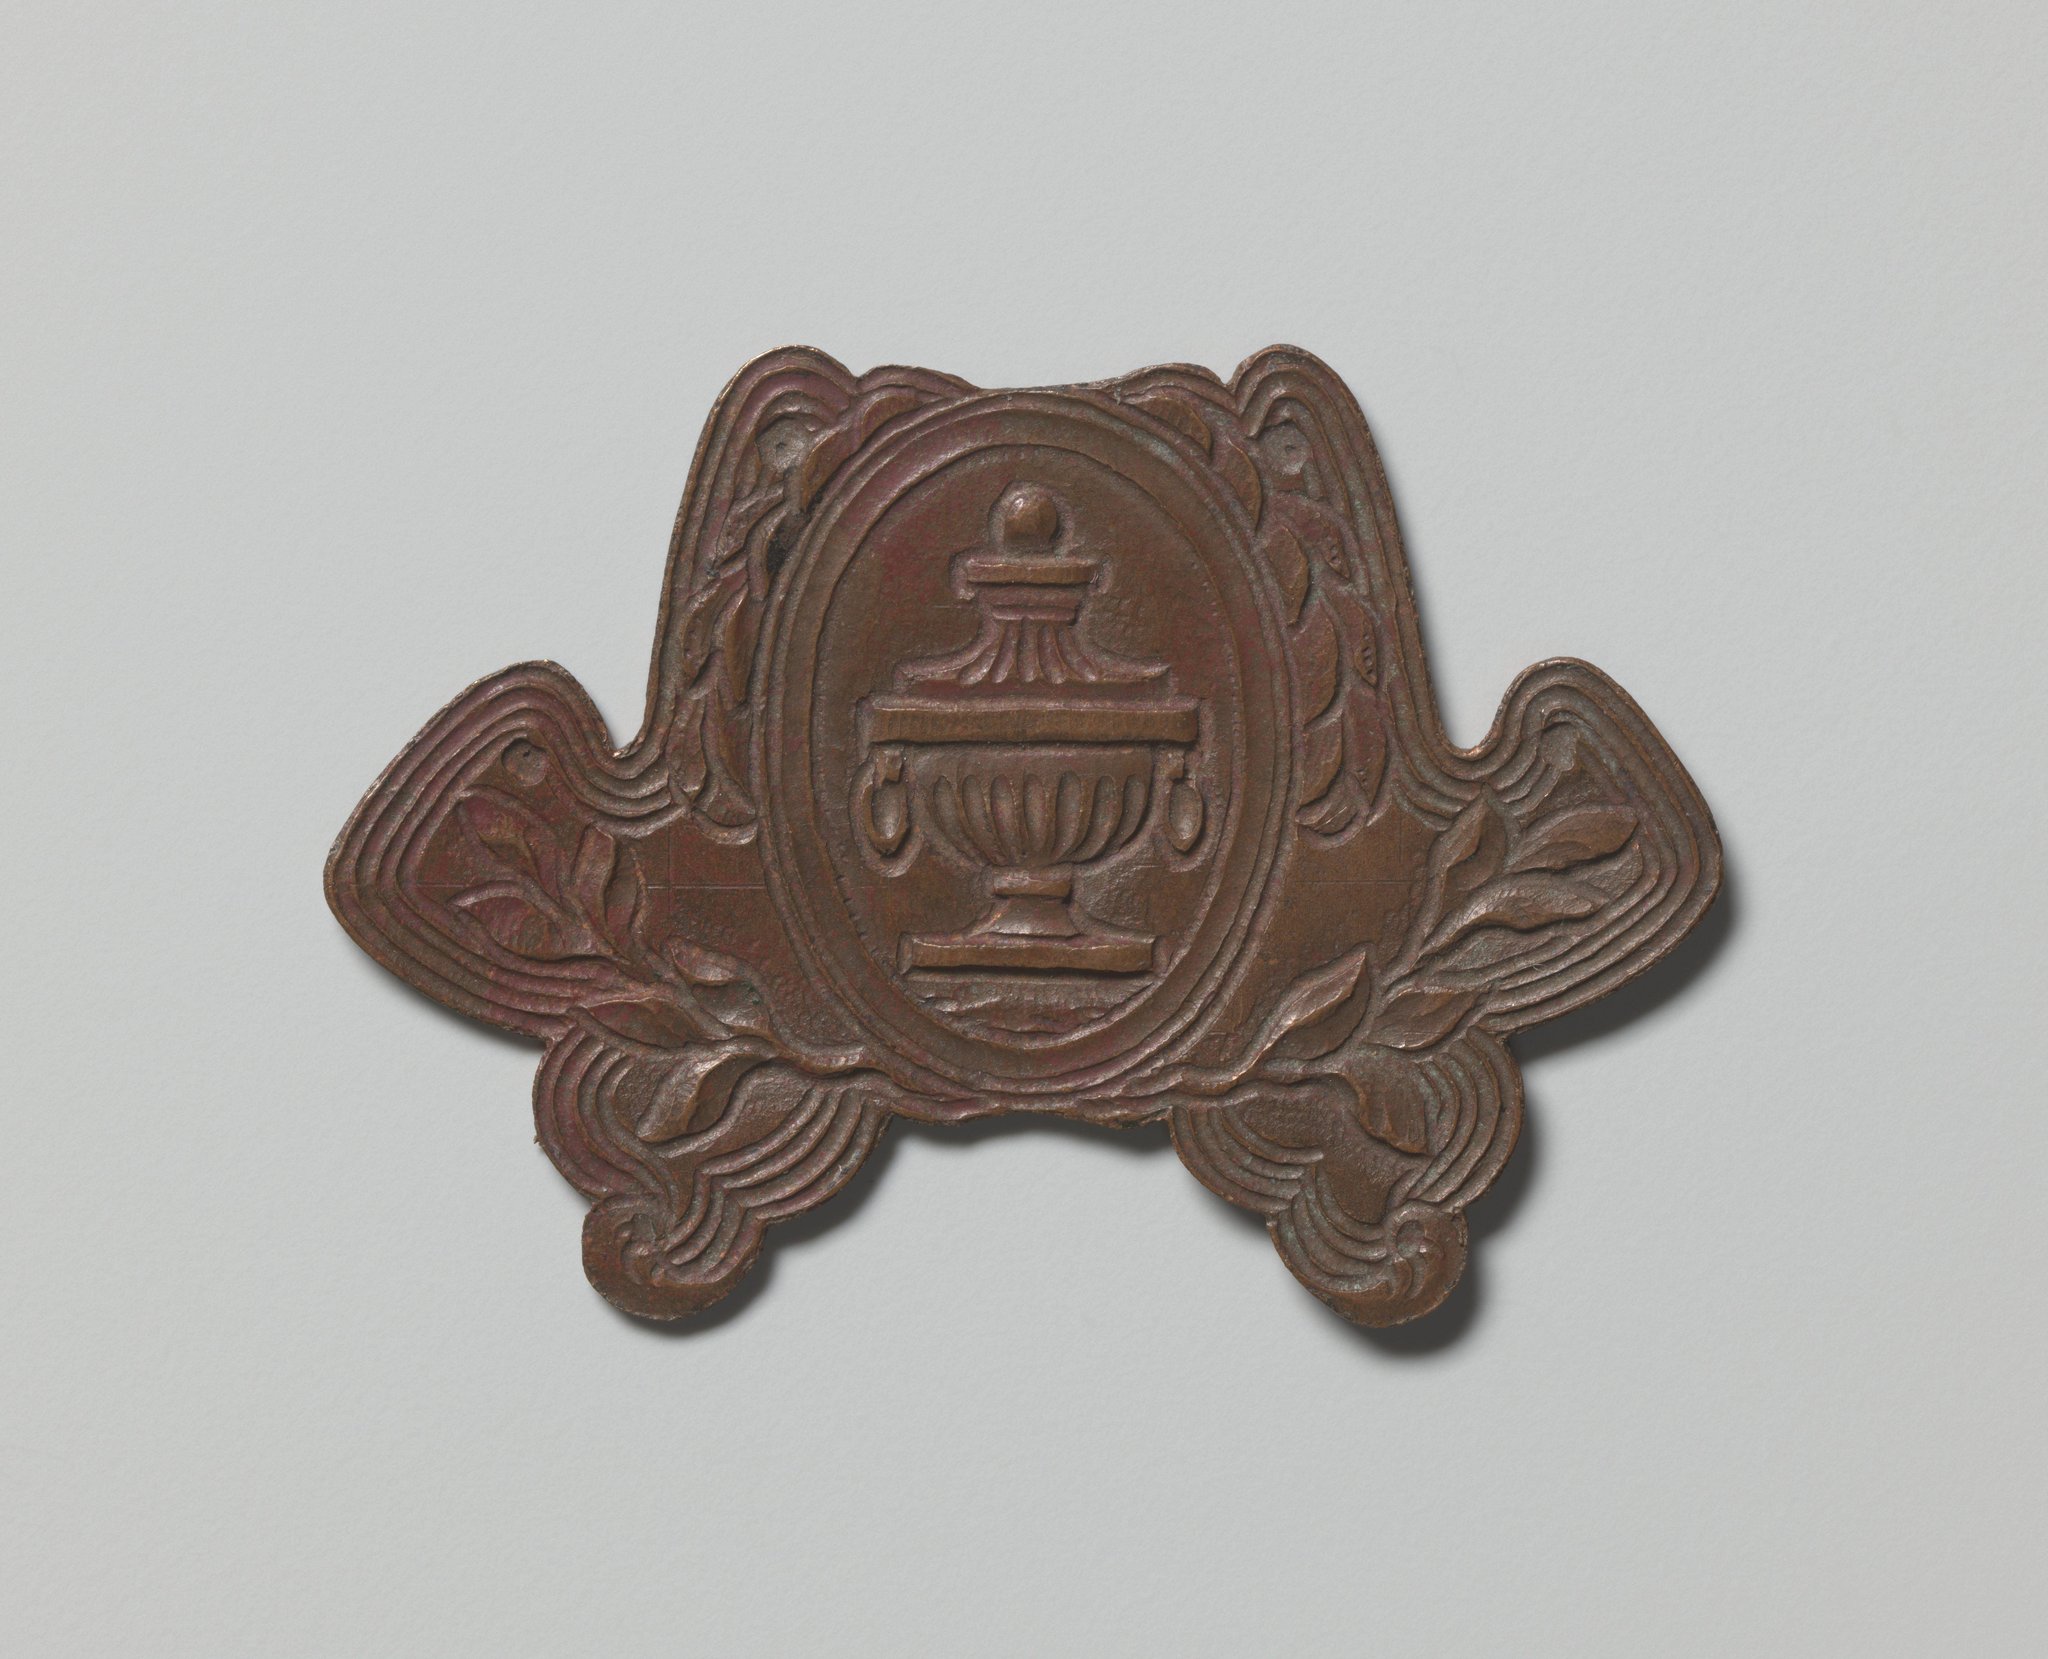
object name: model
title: Model voor een versieringselement van een chatelaine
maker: Anonymous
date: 1775-1800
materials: copper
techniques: repoussé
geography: amsterdam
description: Het uit plaat gedreven model voor een gietvorm is voorzien van een decoratie bestaande uit een vaas in een medaillon, omgeven door slingers en lauwertakken.